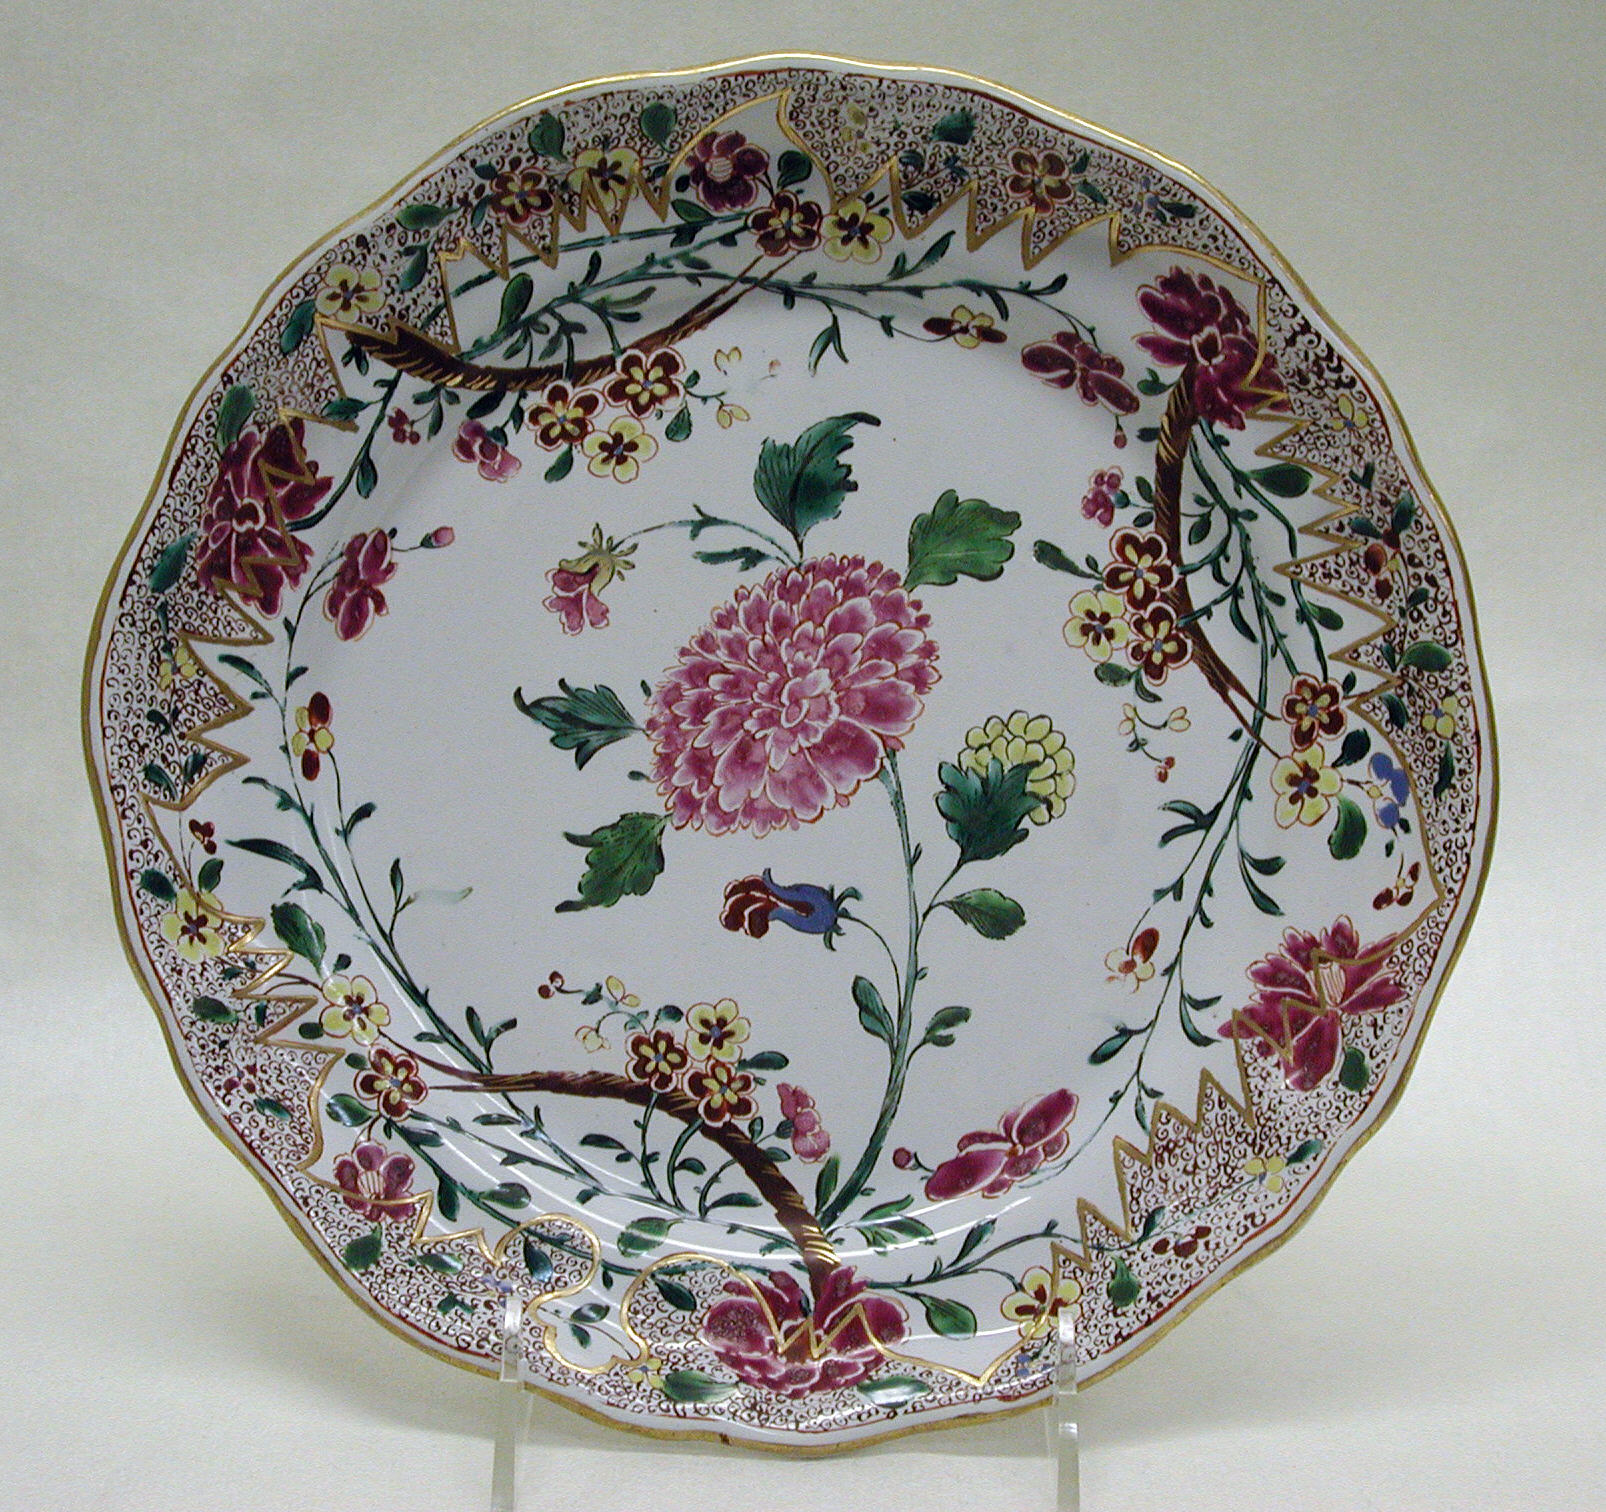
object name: plate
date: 1751-1775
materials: faience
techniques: glazing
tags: flowers